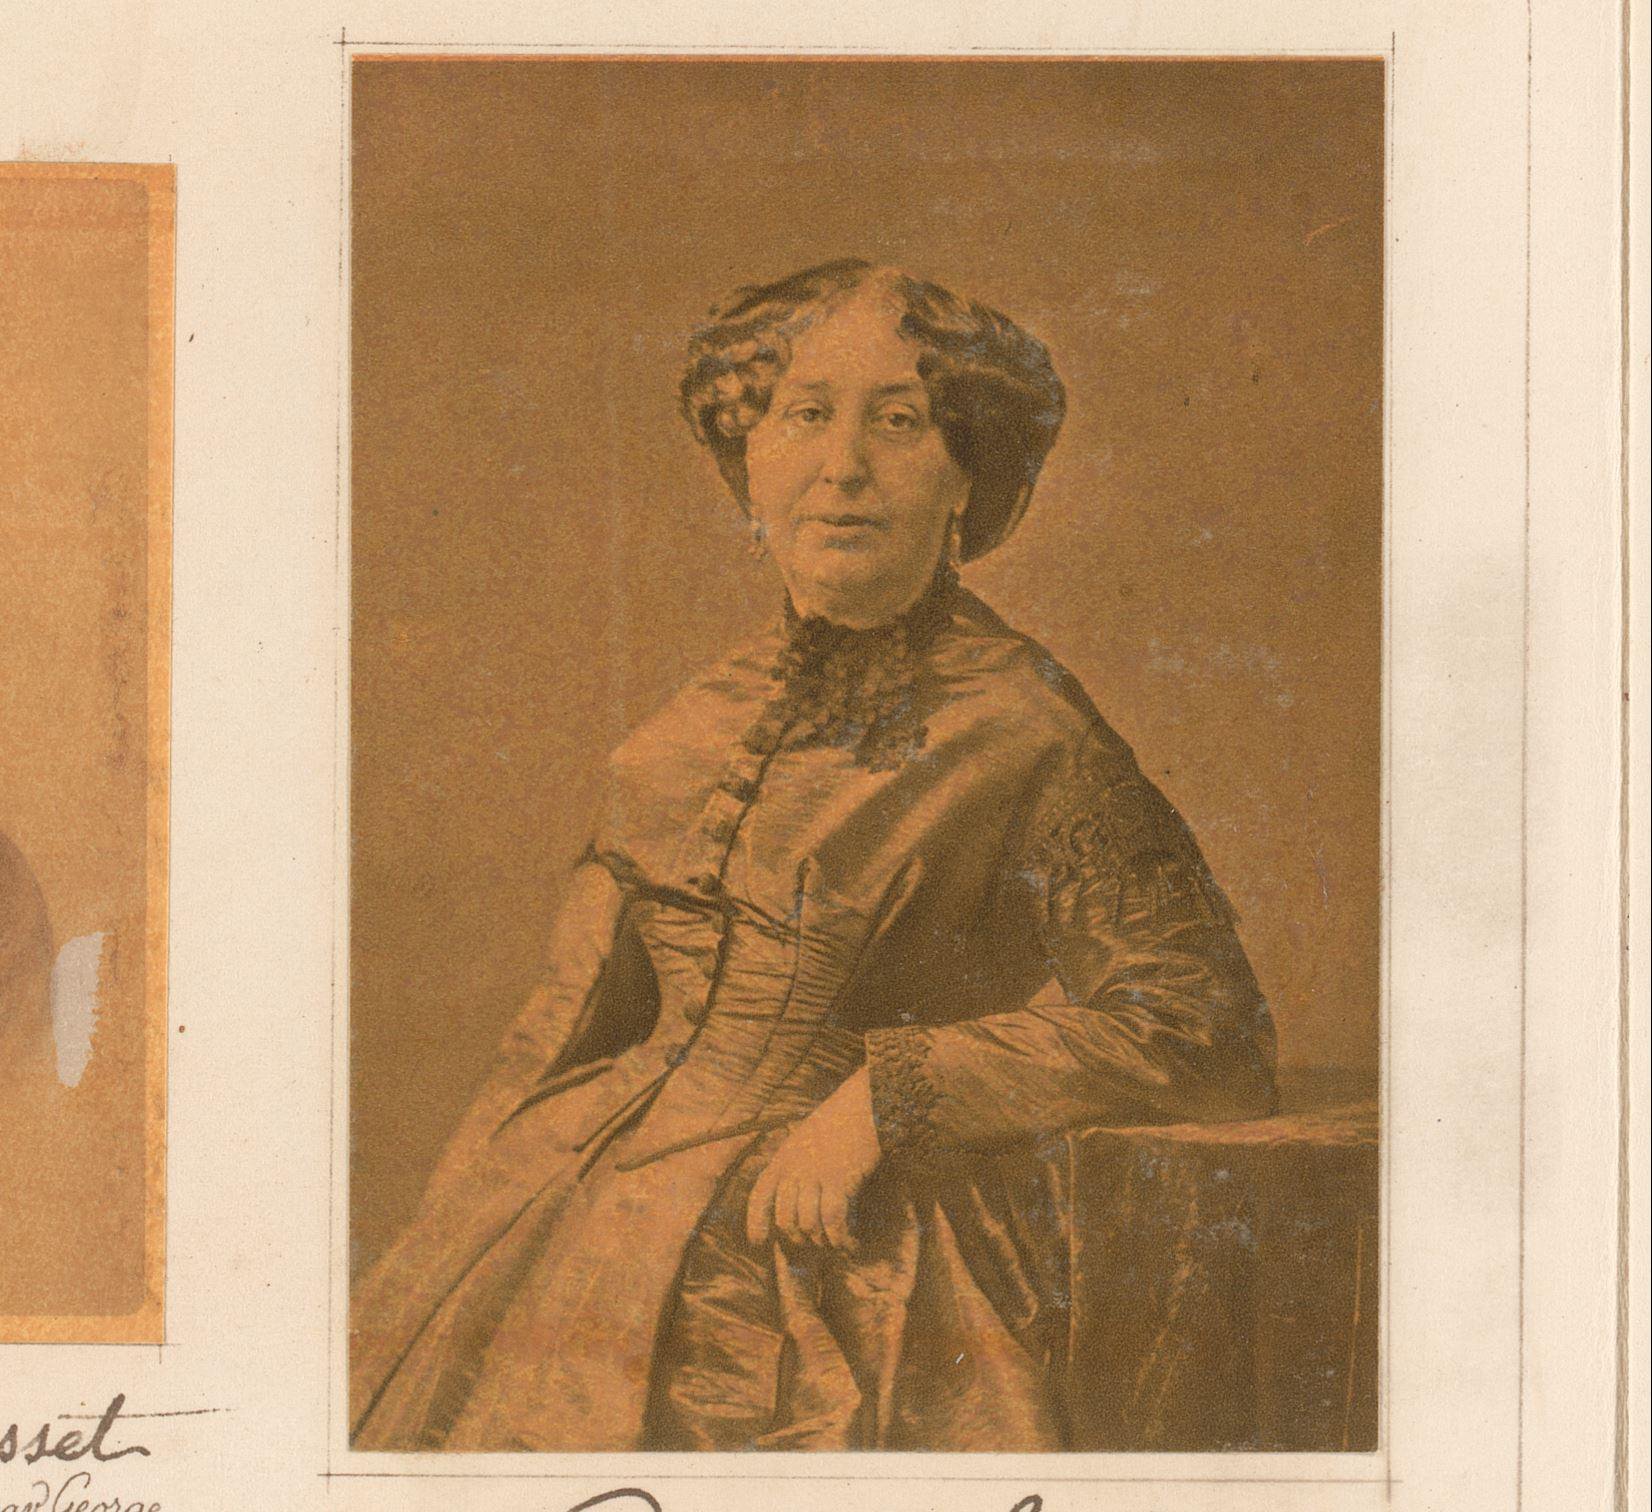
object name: photomechanical print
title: Portret van George Sand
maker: Anonymous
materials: paper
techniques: rotogravure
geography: france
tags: paris, george sand, portrait of a writer, france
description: Deze prent maakt deel uit van een album.